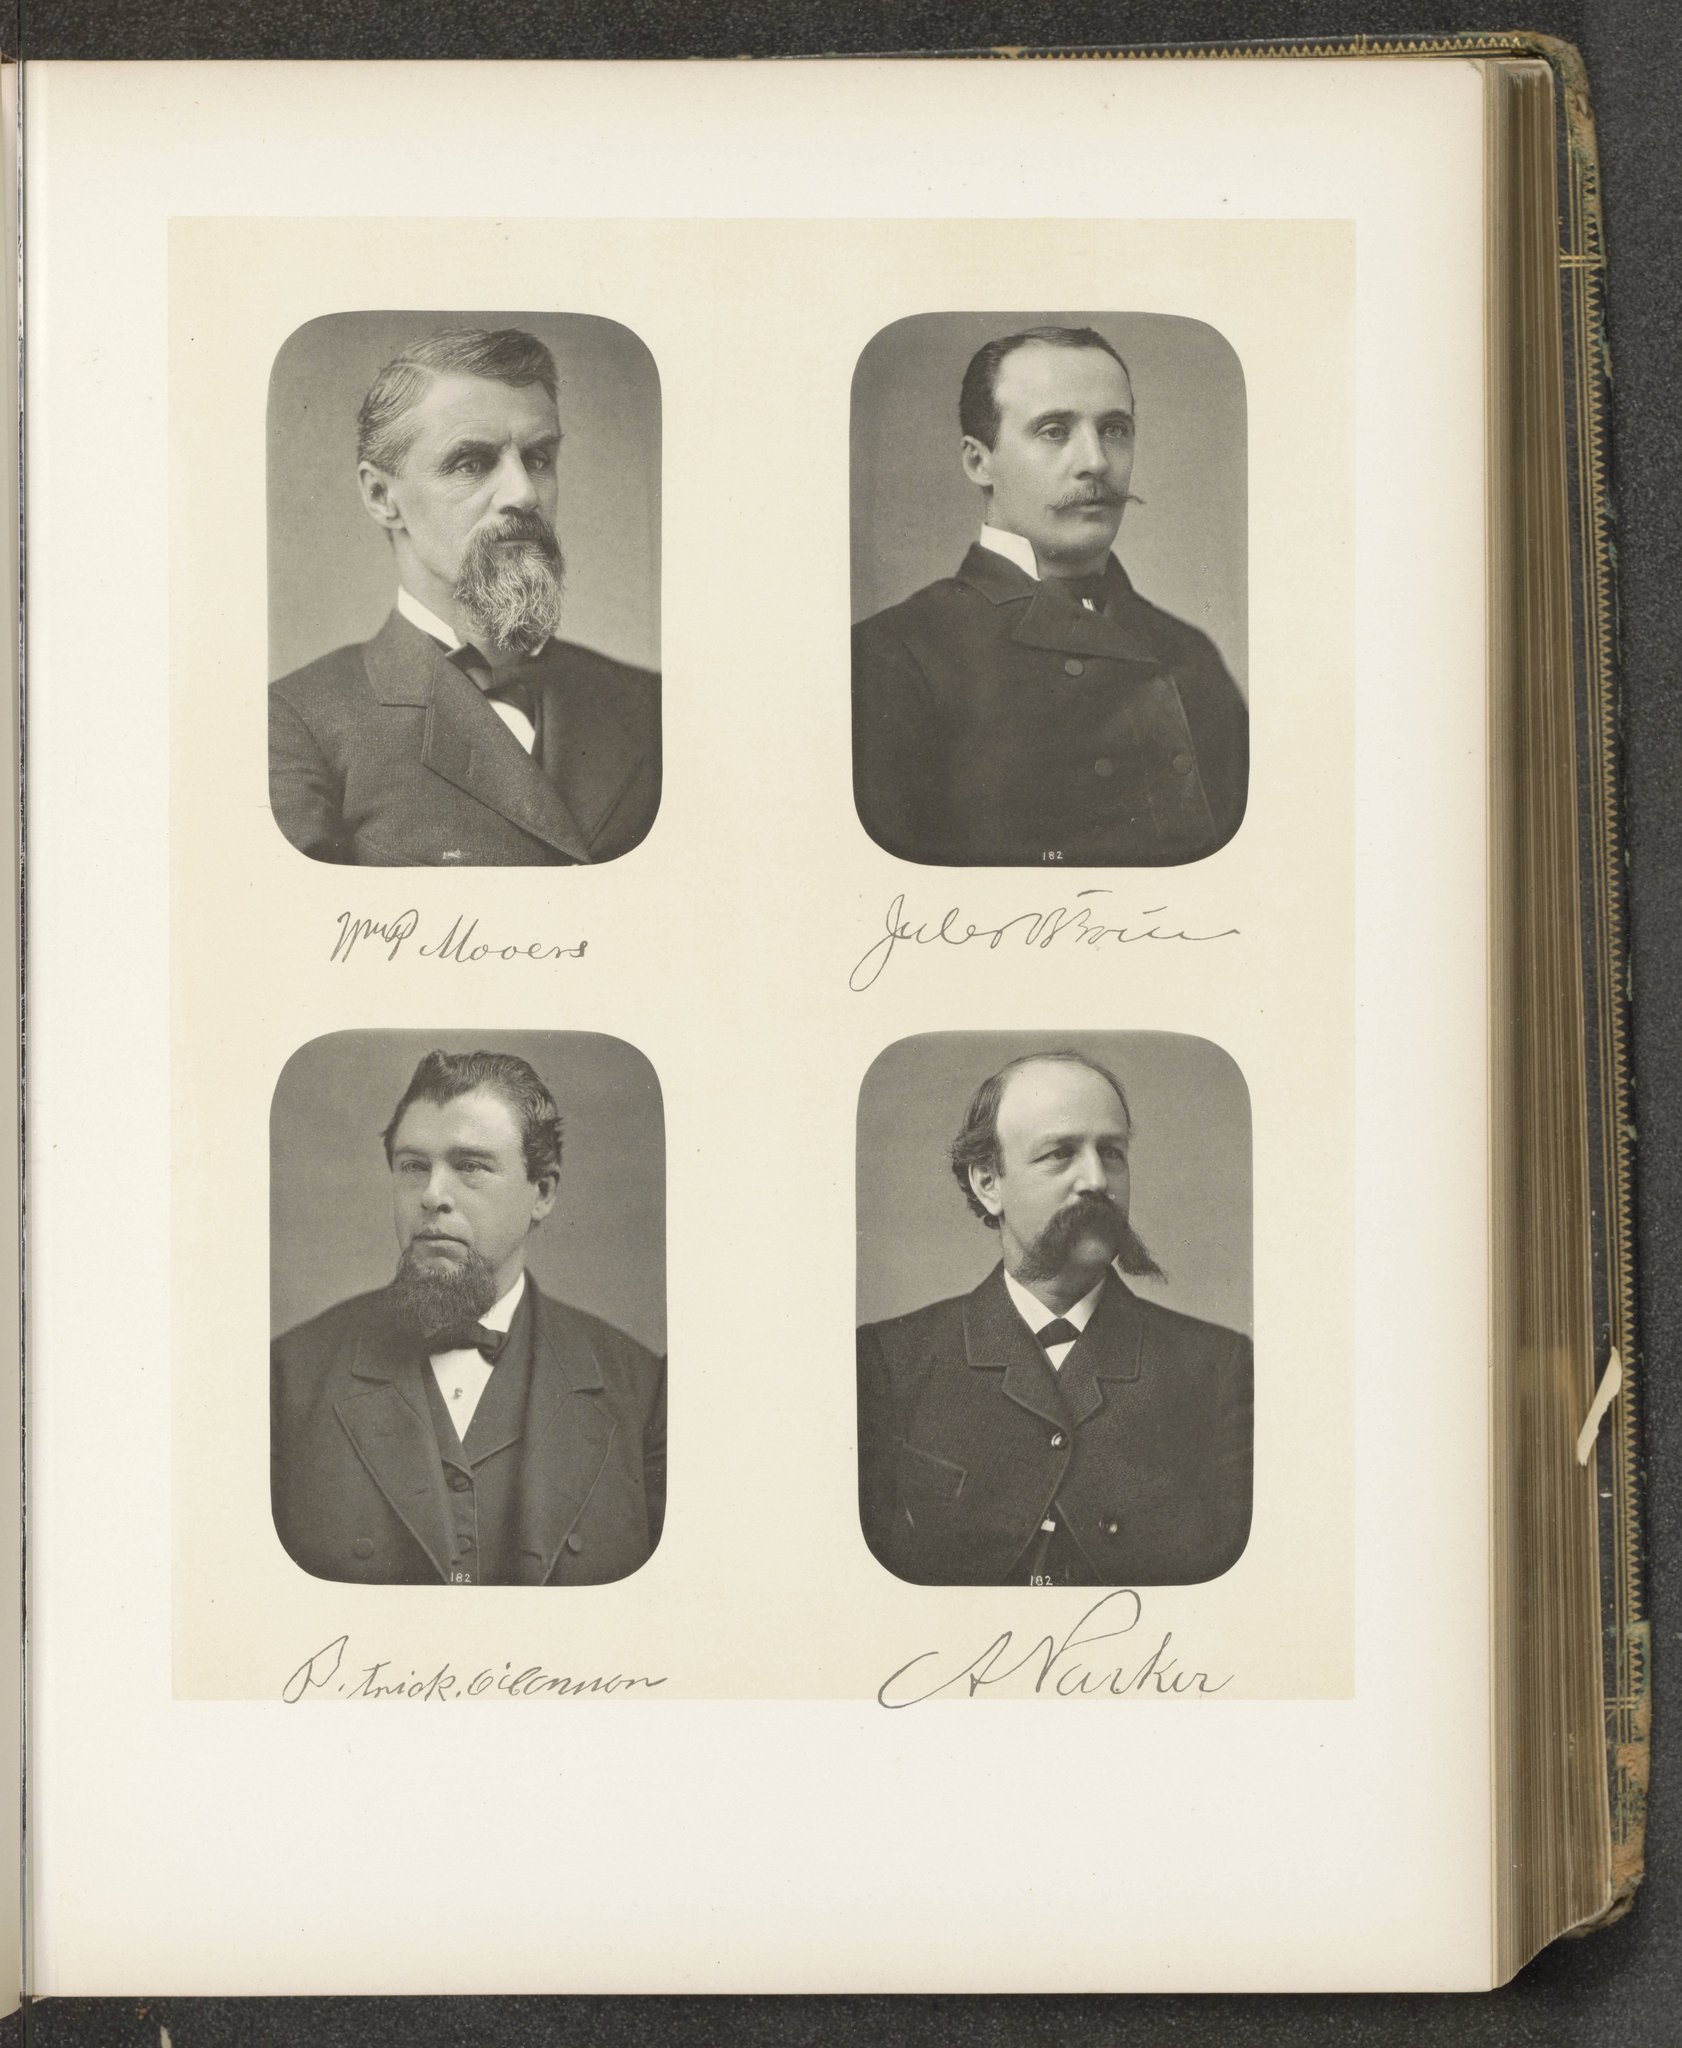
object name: page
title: Portretten van vier leden van het Lagerhuis van de staat New York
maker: Anonymous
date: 1872-1882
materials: paper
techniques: photograph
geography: united states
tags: historical persons (portraits and scenes from the life) (+ head (and shoulders) (portrait))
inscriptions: annotation, number: ‘182’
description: Linksboven William P. Mooers, rechtsboven Jules O'Brien, linksonder Patrick O'Connor, rechtsonder Albert Parker.